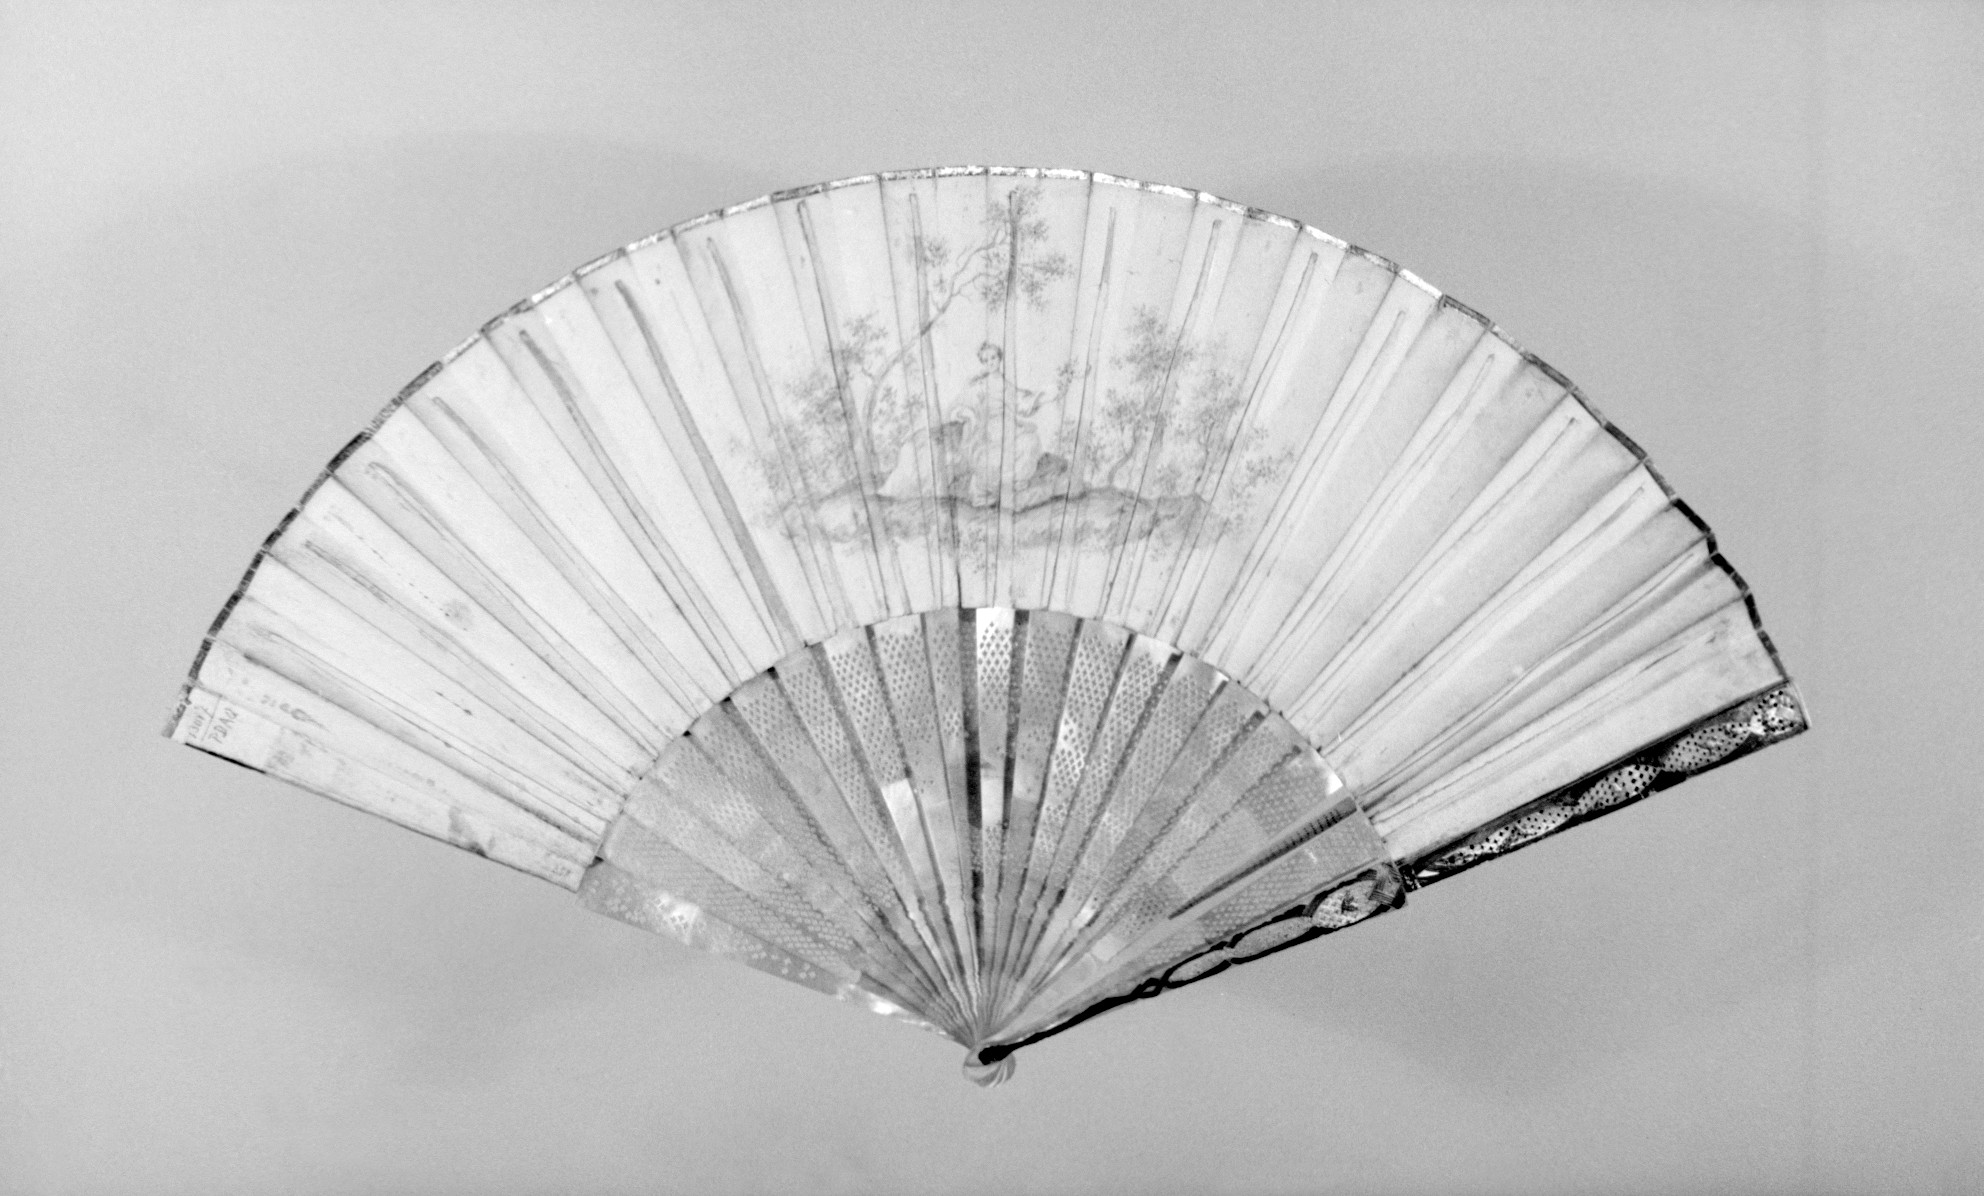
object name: fan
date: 1701-1800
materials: mother of pearl, parchment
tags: children,men,women